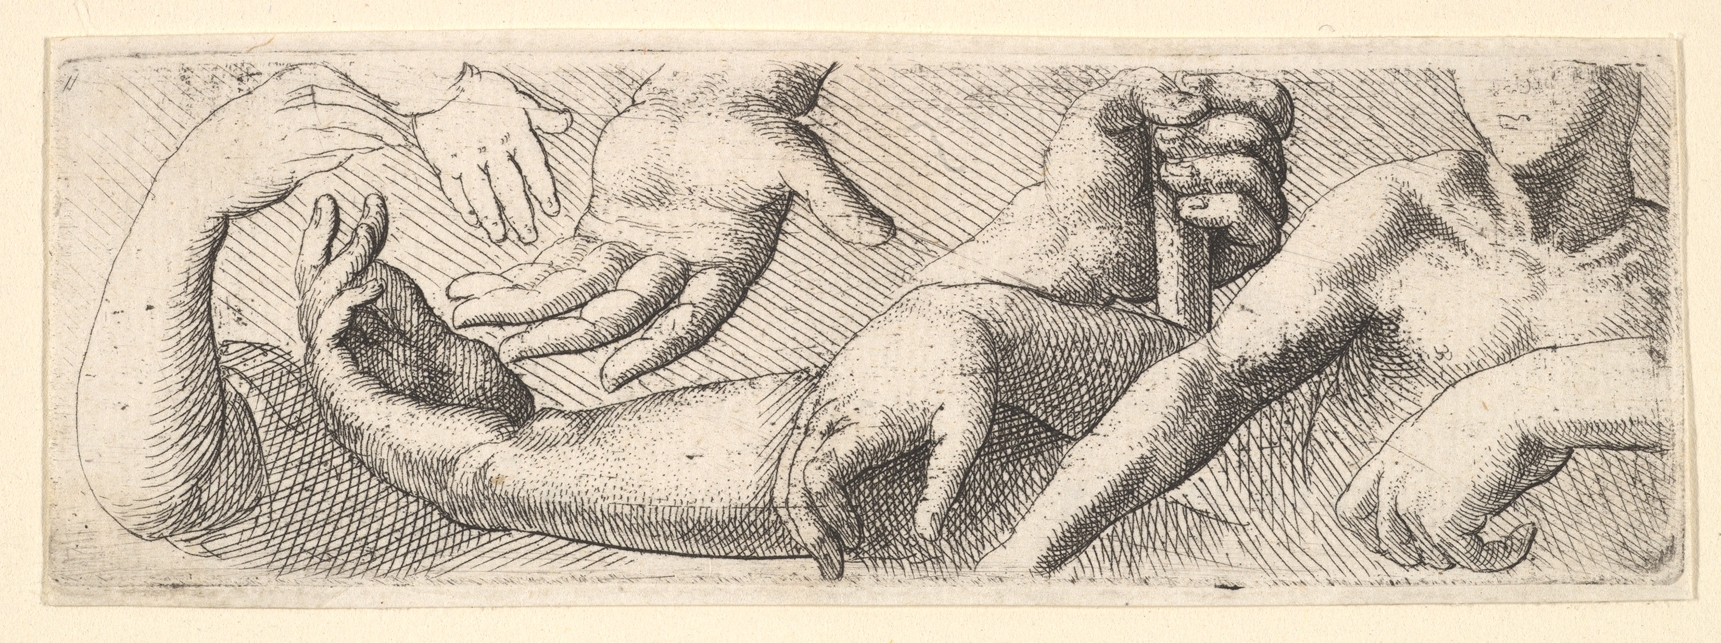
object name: print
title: Hands and arms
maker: wenceslaus hollar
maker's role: artist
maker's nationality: bohemian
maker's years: 1607-1677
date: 1644-1652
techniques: etching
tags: hands